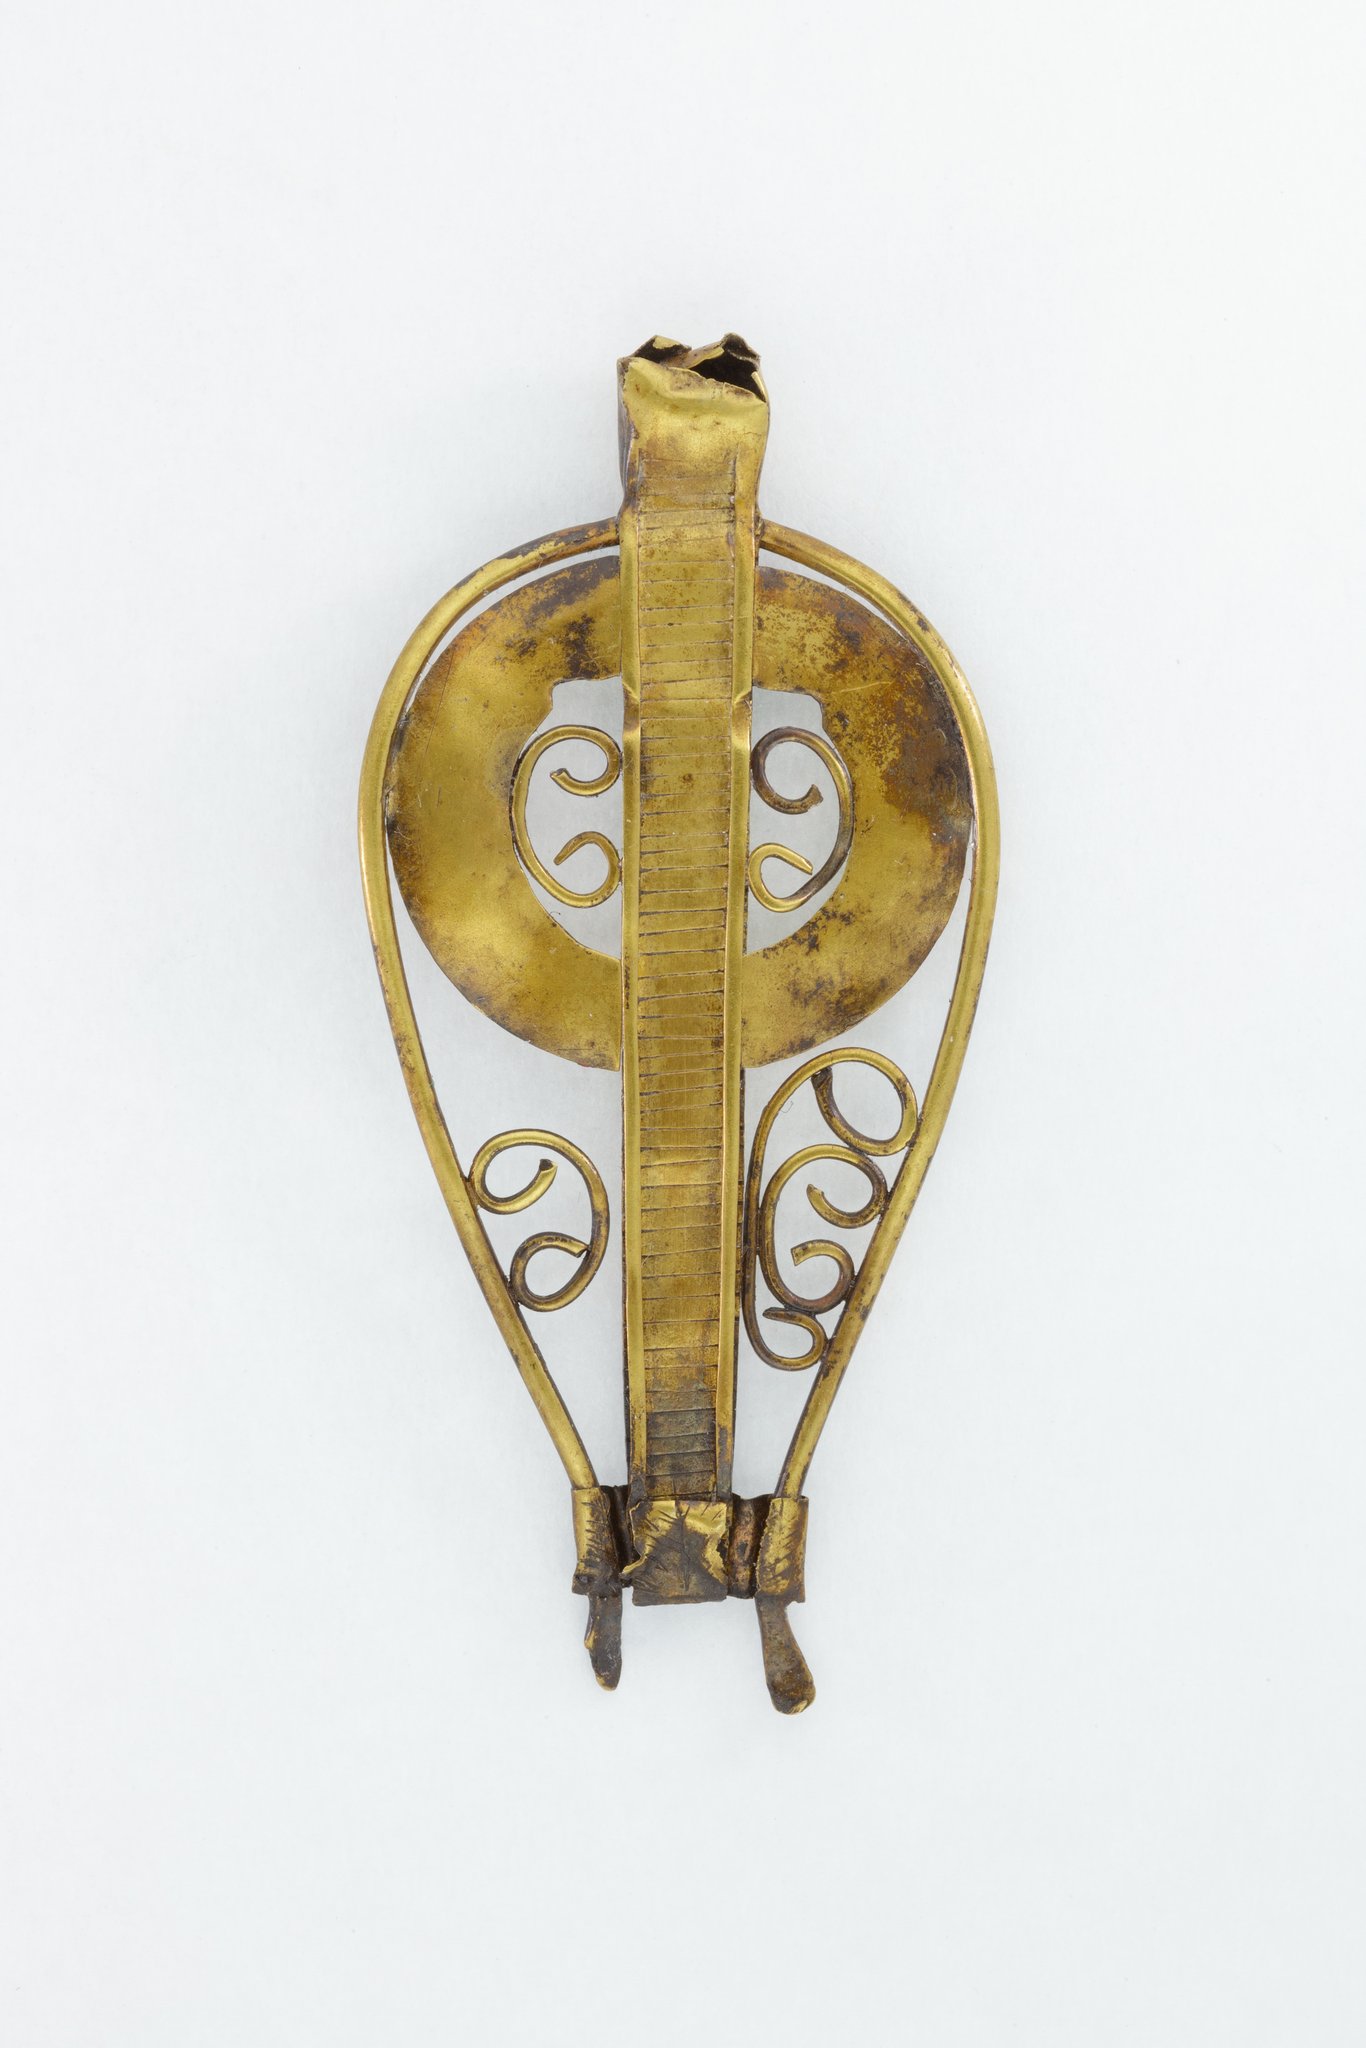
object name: pendant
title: Pendant in the Shape of an Uraeus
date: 2030-1650 BCE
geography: upper egypt, thebes